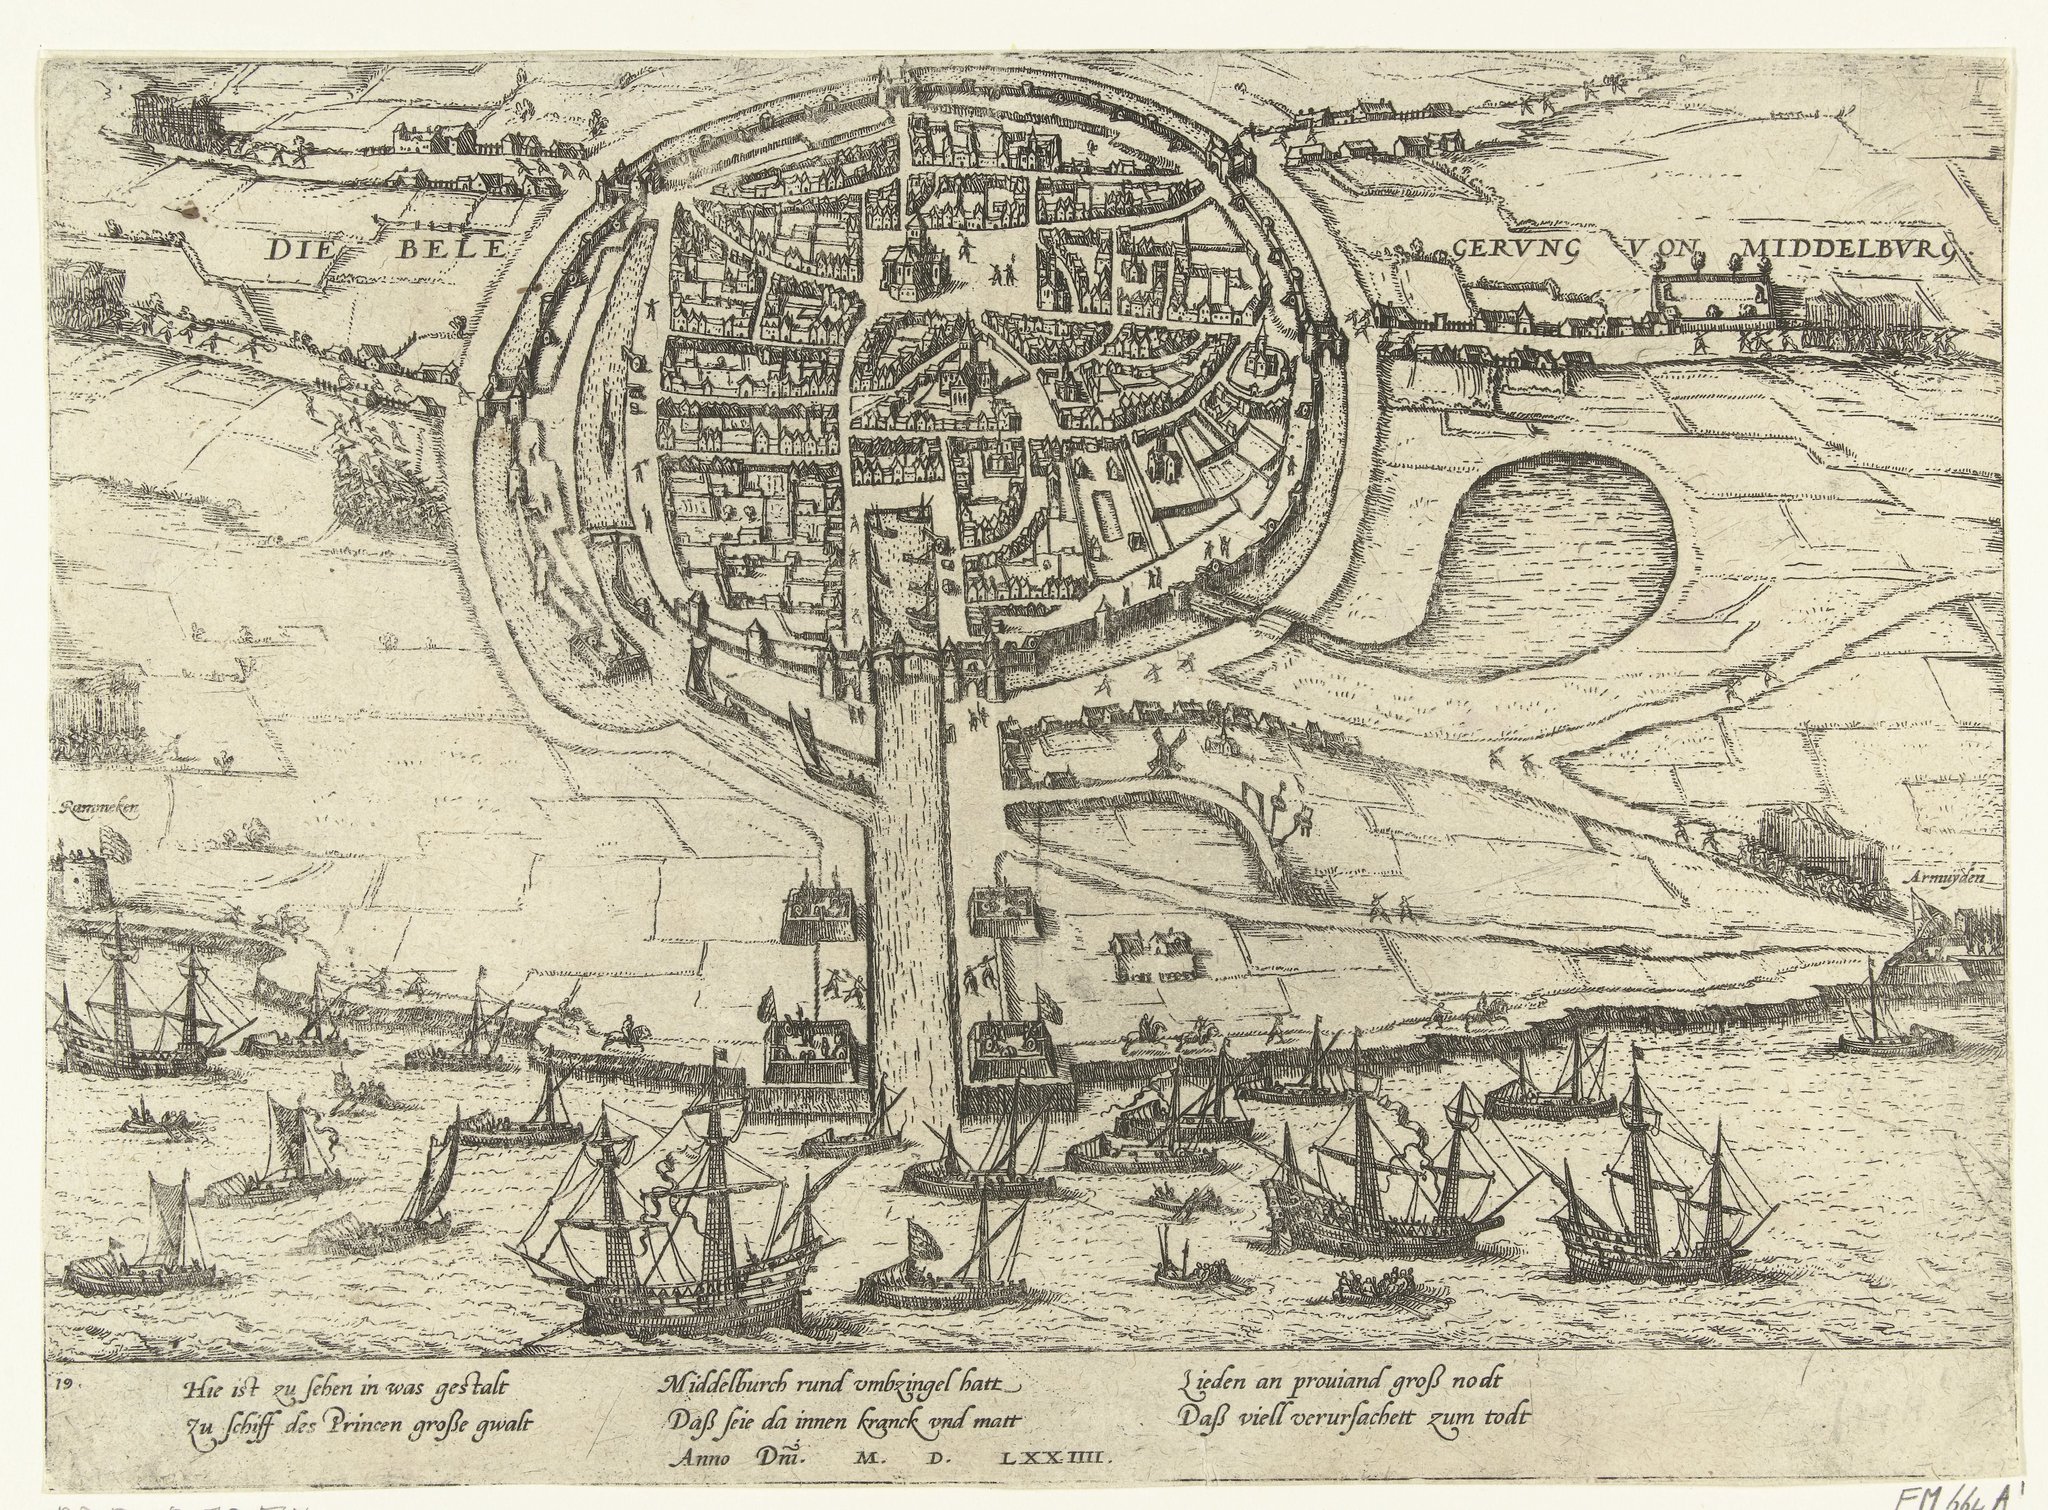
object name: print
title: Beleg van Middelburg, 1574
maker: frans hogenberg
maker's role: print maker, publisher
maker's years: 1538-1590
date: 1574-1576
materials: paper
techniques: etching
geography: cologne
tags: siege, position war, middelburg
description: Beleg van Middelburg door de opstandelingen, januari 1574. Gezicht op de belegerde stad en de omgeving. Op de voorgrond de schepen van de geuzen, Fort Rammekens en Arnemuiden. Met onderschrift van 6 regels in het Duits. Genummerd: 19.